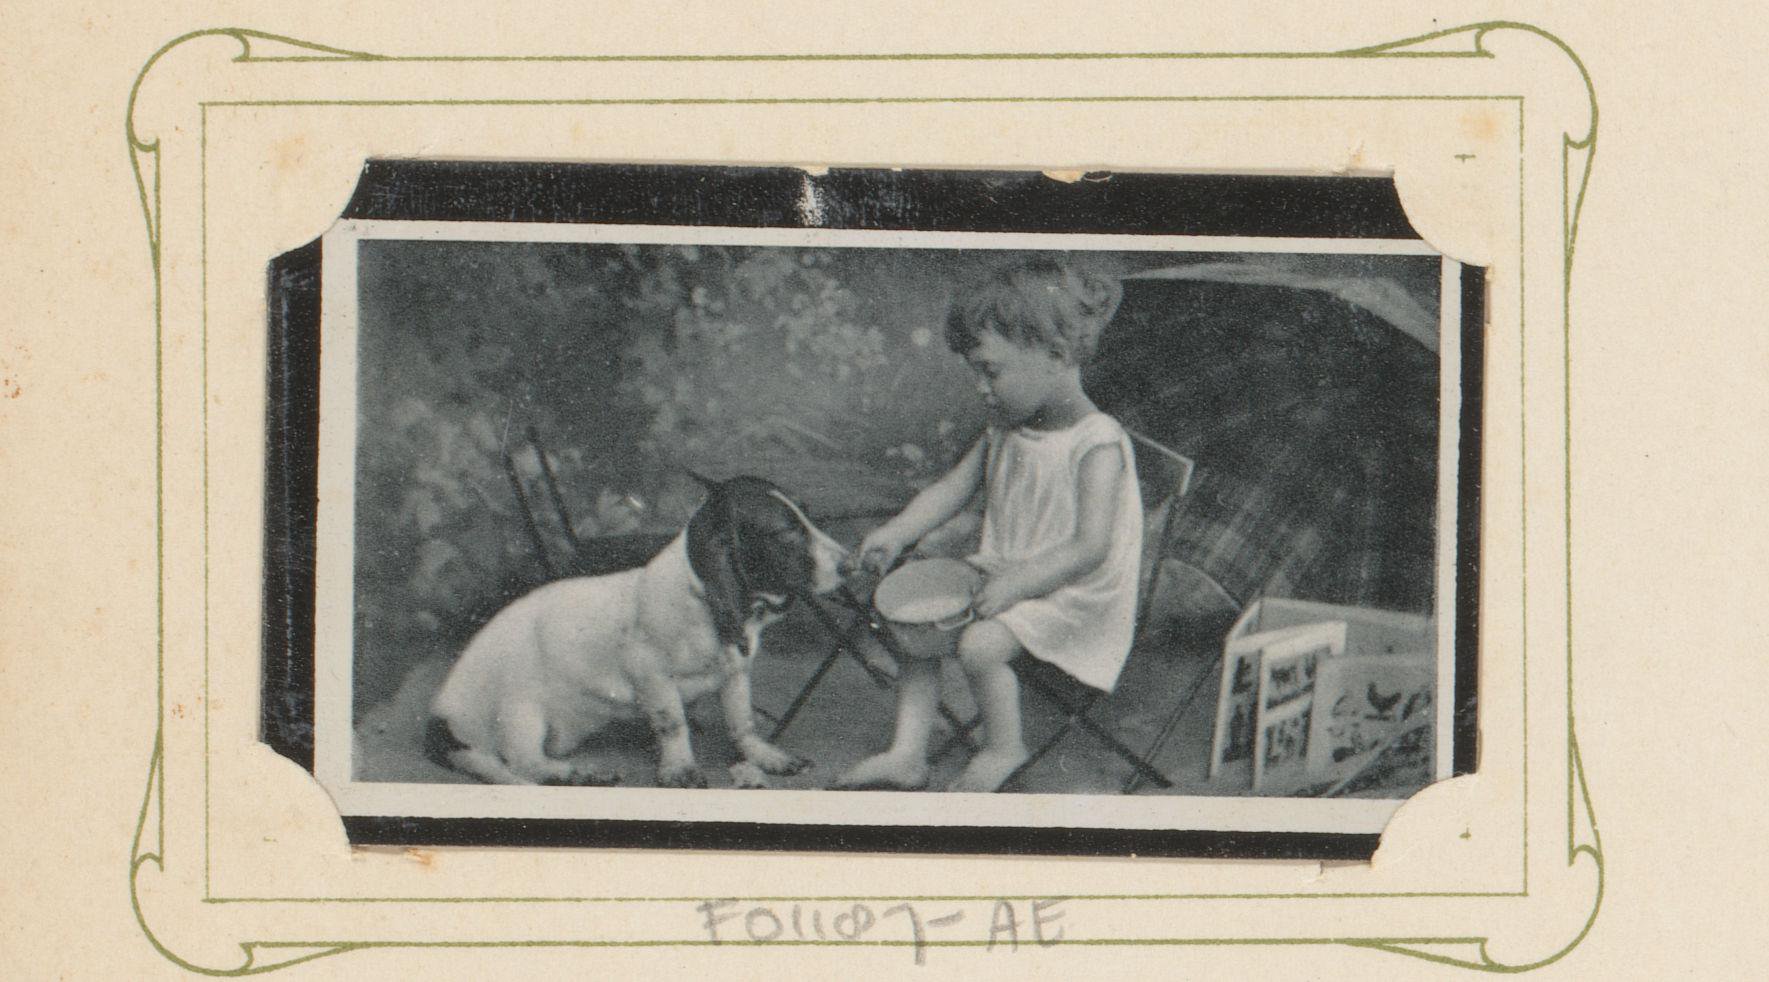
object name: photomechanical print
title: Kind op een kruk en een hond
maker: Anonymous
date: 1905-1906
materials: paper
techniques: photograph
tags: stool, tot, toddler ~ the ages of man, dog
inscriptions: inscription: ‘No. 1./ Twee vrienden - het kind en de hond.’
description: Deze prent maakt deel uit van een album.